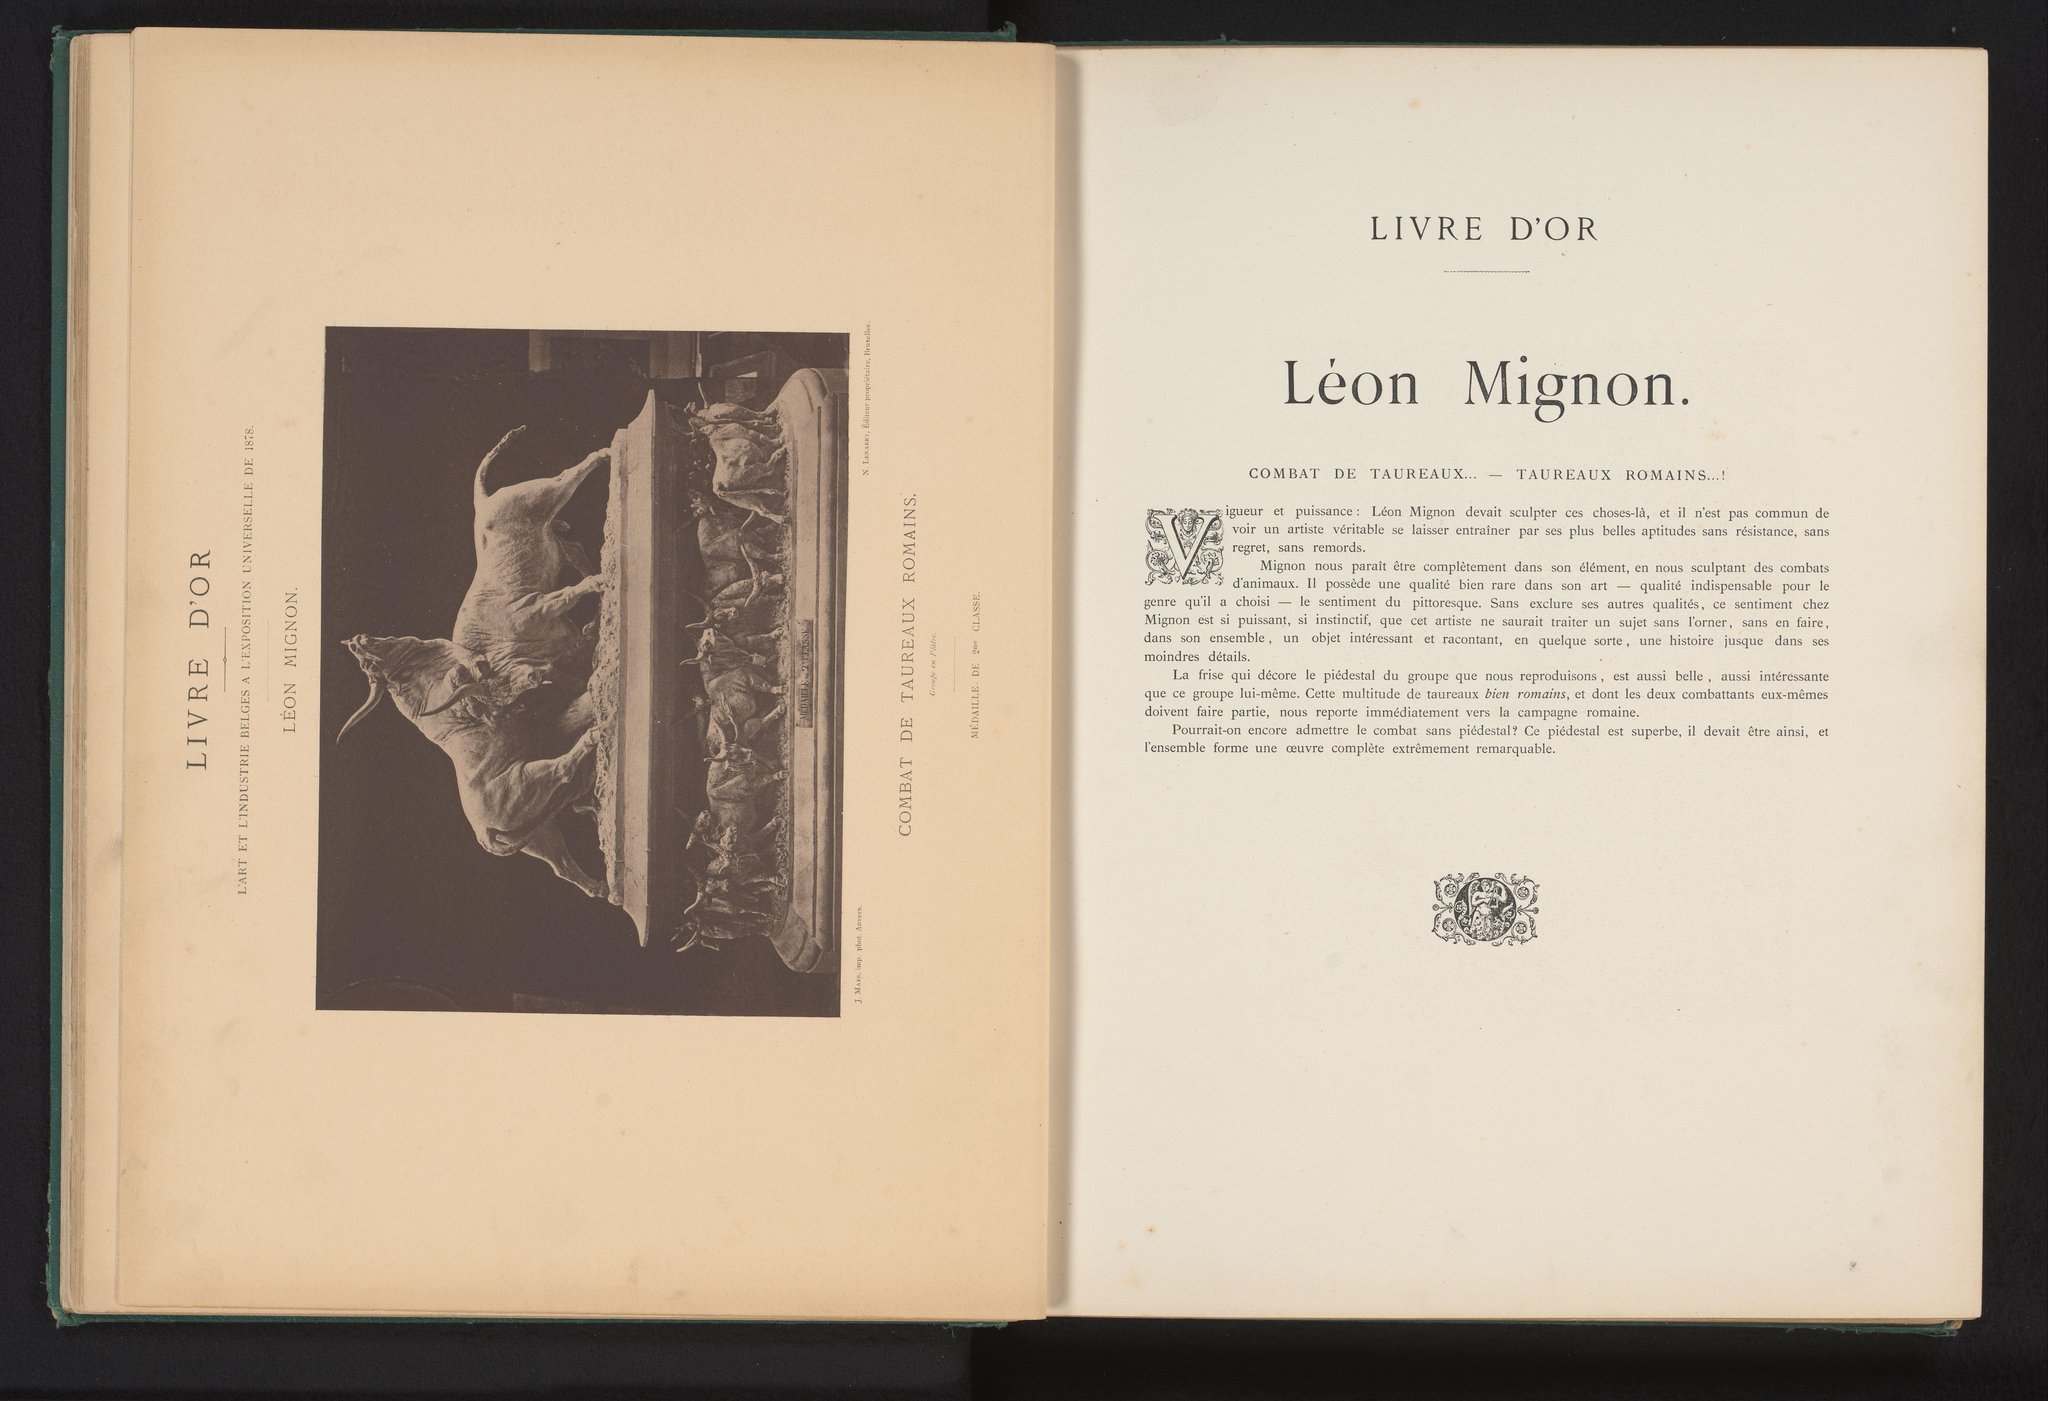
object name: photomechanical print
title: Groep met vechtende stieren vervaardigd door Léon Mignon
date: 1874-1879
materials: paper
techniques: photograph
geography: antwerp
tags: bullfight, sculpture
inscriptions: inscription: ‘Livre d'or/ L'art et l'industrie Belges a l'exposition universelle de 1878.’, inscription: ‘Groupe en Plàtre’